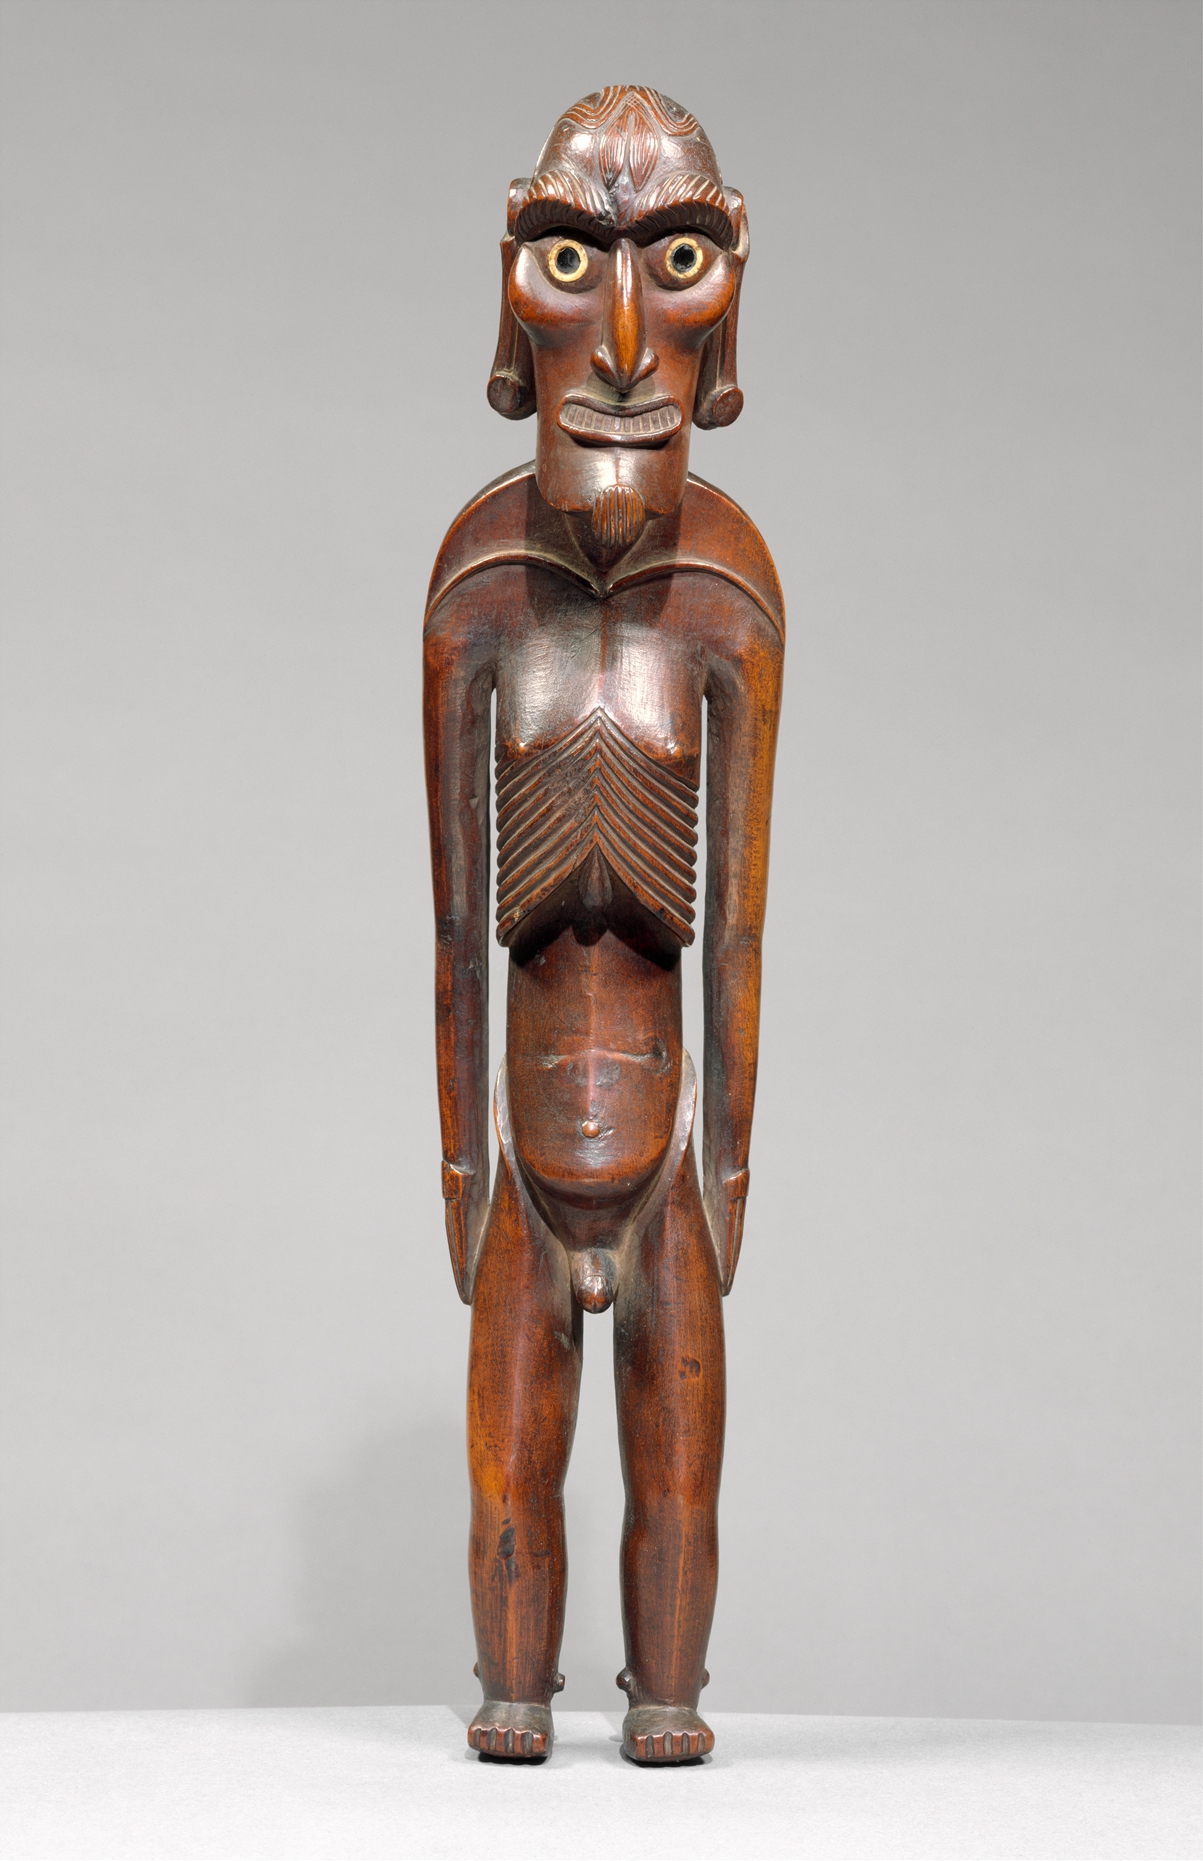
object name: figure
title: Male Figure (Moai Kavakava)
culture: rapa nui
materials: bone, obsidian, wood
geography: chile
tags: male nudes